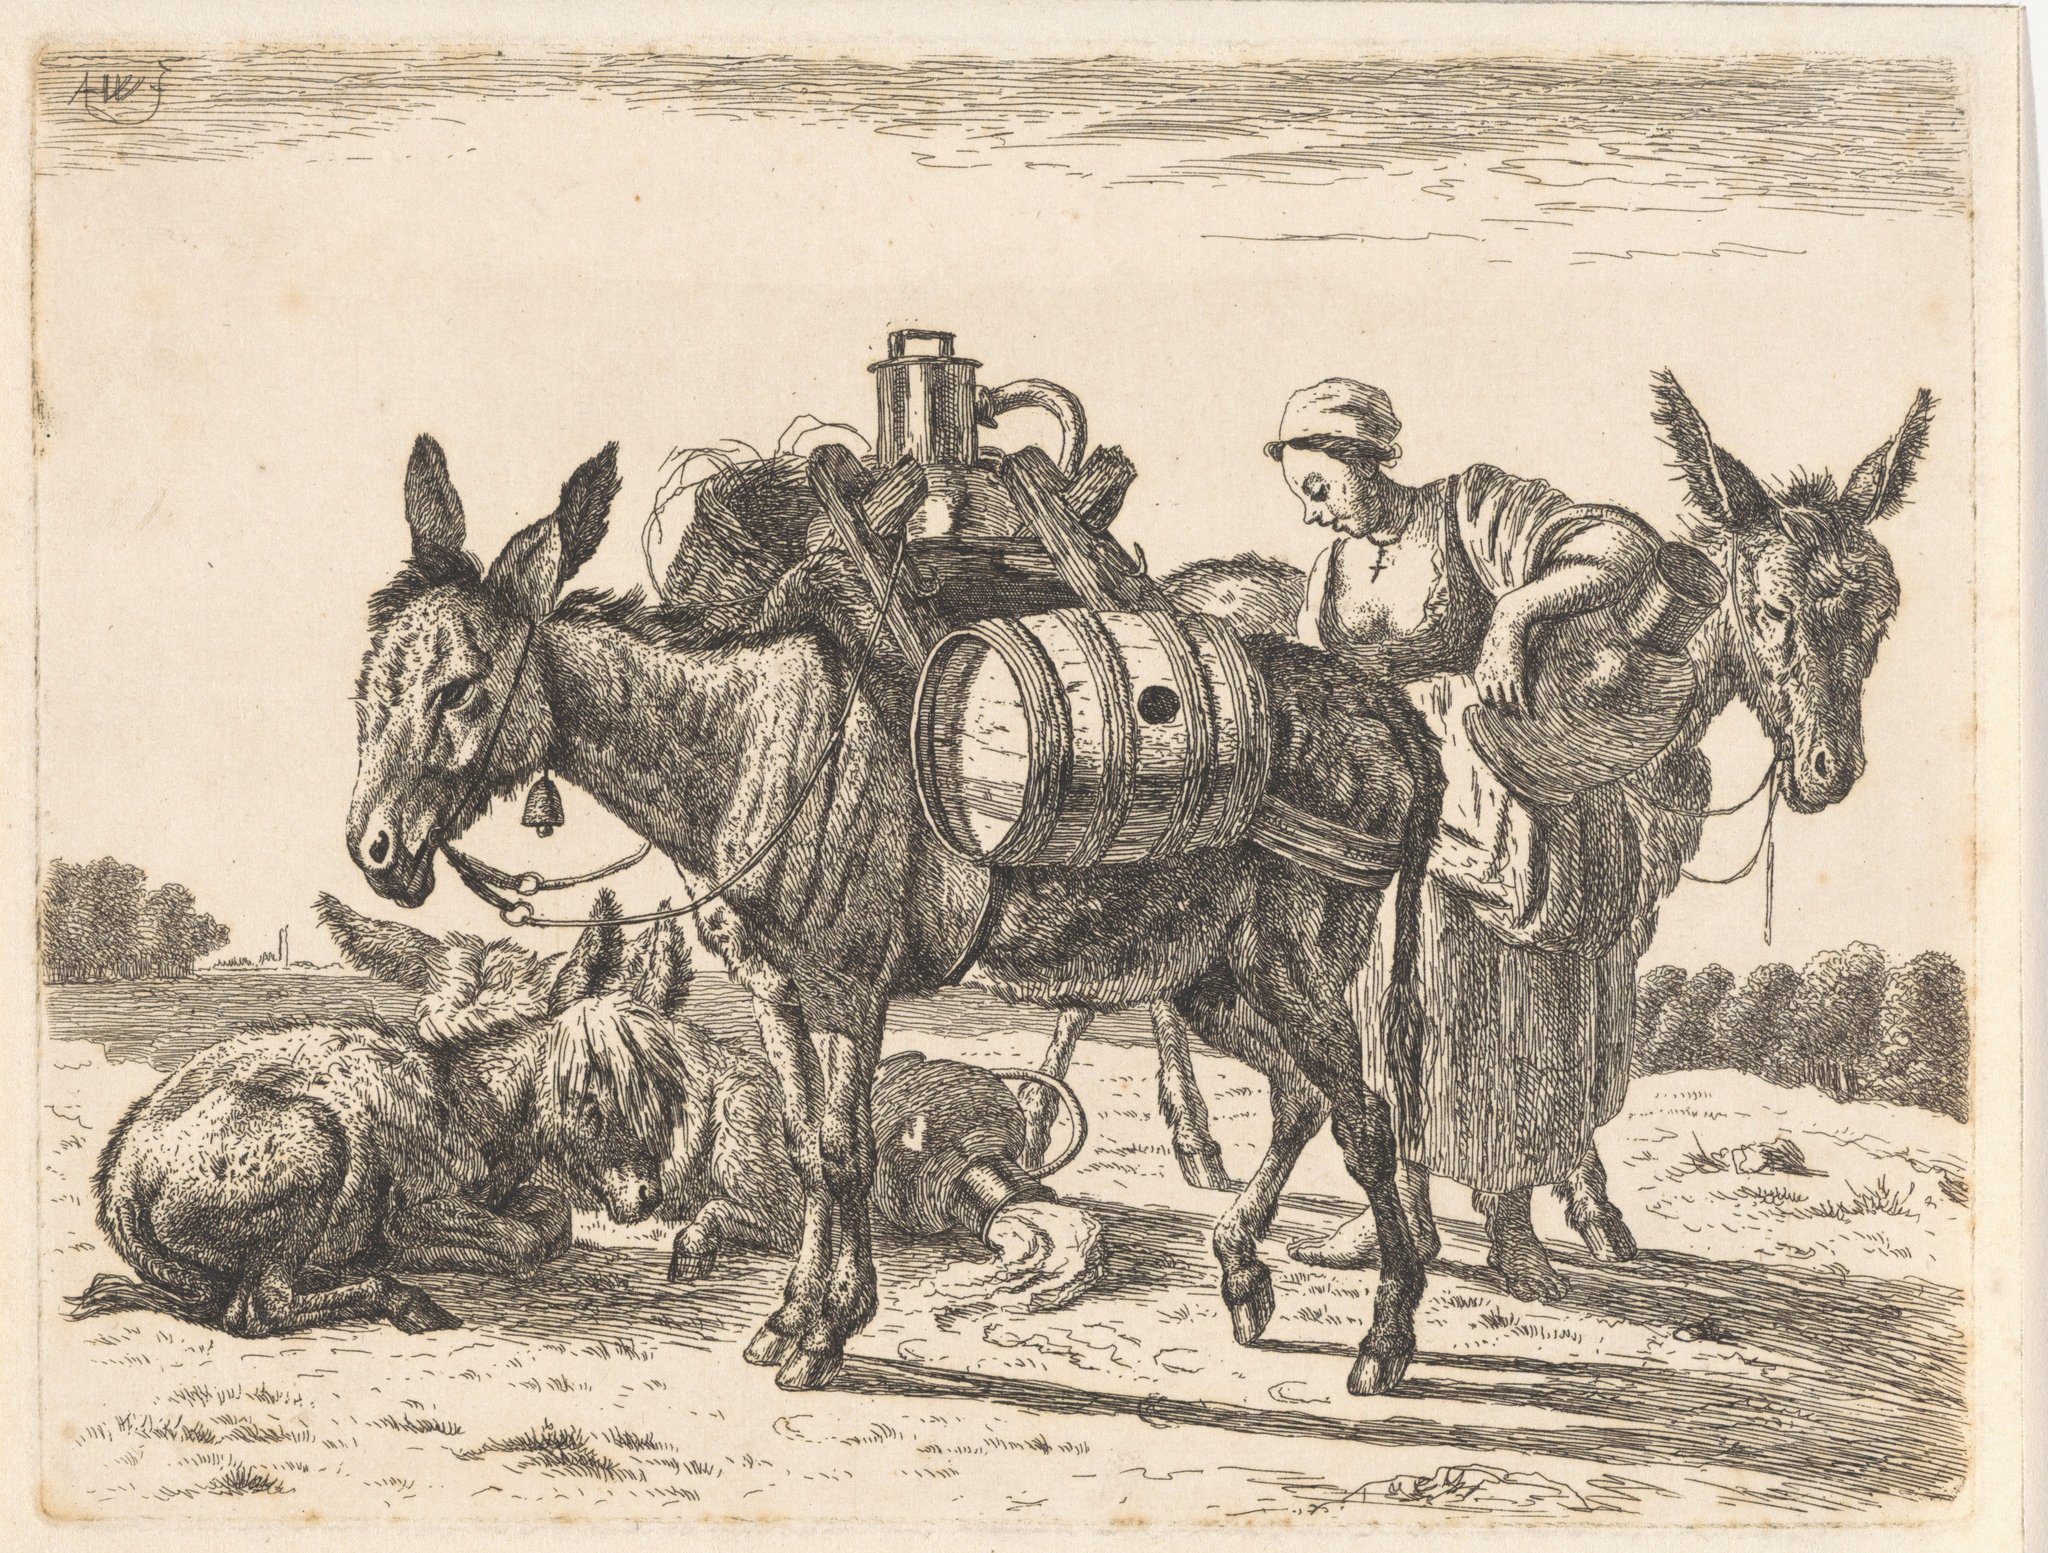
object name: print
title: Pakezels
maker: abraham hendrik winter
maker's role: painter, print maker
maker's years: 1800-1861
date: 1815-1860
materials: paper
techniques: etching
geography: utrecht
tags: adult woman, ass, donkey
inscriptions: collector's mark: Lugt 2228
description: Een vrouw staat tussen twee pakezels. Op de grond liggen twee jonge ezels bij een omgevallen kan.